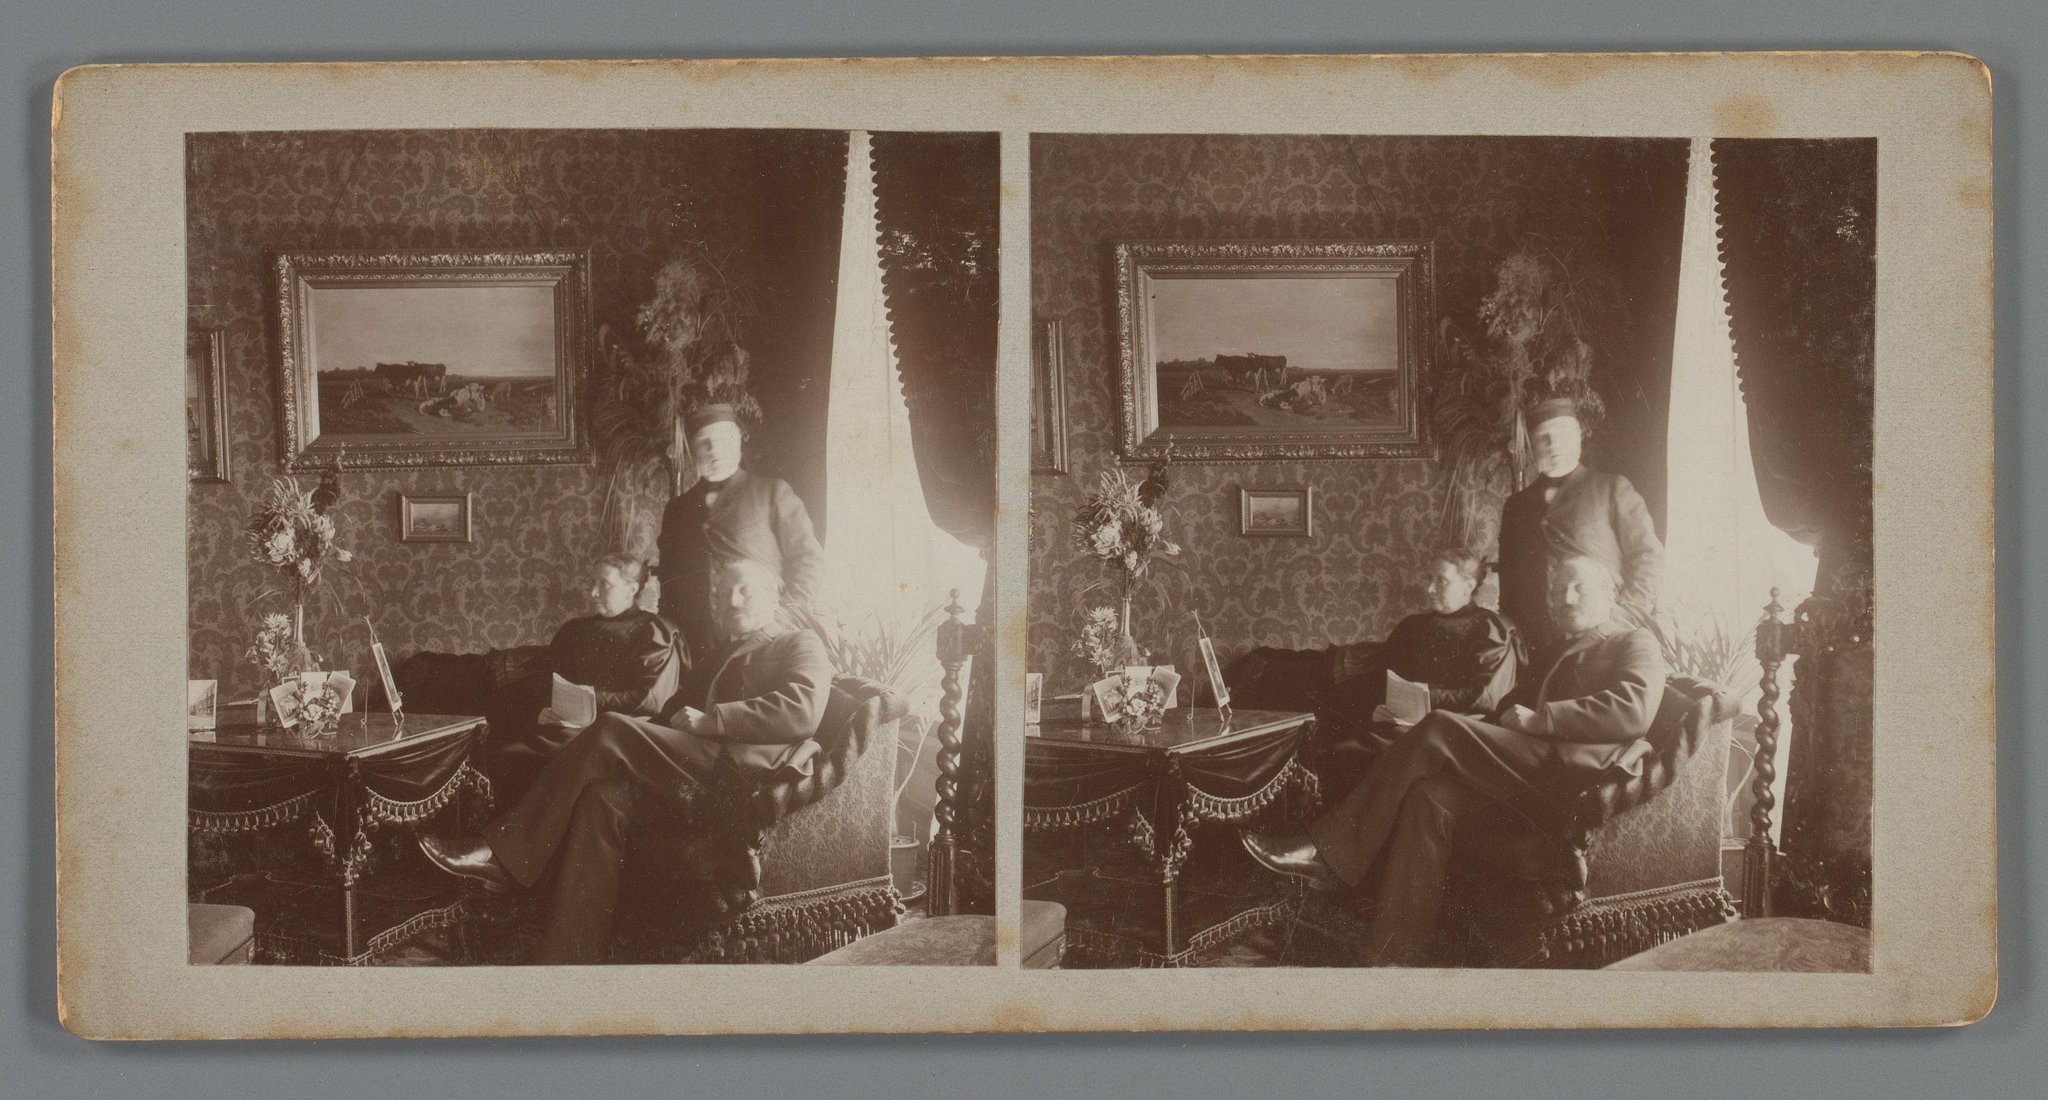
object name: stereograph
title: Portret van Piet de Jong met ouders Johanna de Jong-Voet en Lambertus de Jong in zijn huis in Arnhem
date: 1900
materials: paper, cardboard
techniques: collodion silver print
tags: leiden, lambertus de jong, arnhem, johanna petronella de jong-voet, piet de jong (fotograaf), historical persons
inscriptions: inscription: ‘Lambertus de Jong/ mevrouw J. de Jong-Voet/ + zoon/ Piet de Jong’, address: ‘Velperplein/ 14/ Arnhem’, inscription: ‘(huis/ Piet/ de/ Jong)’